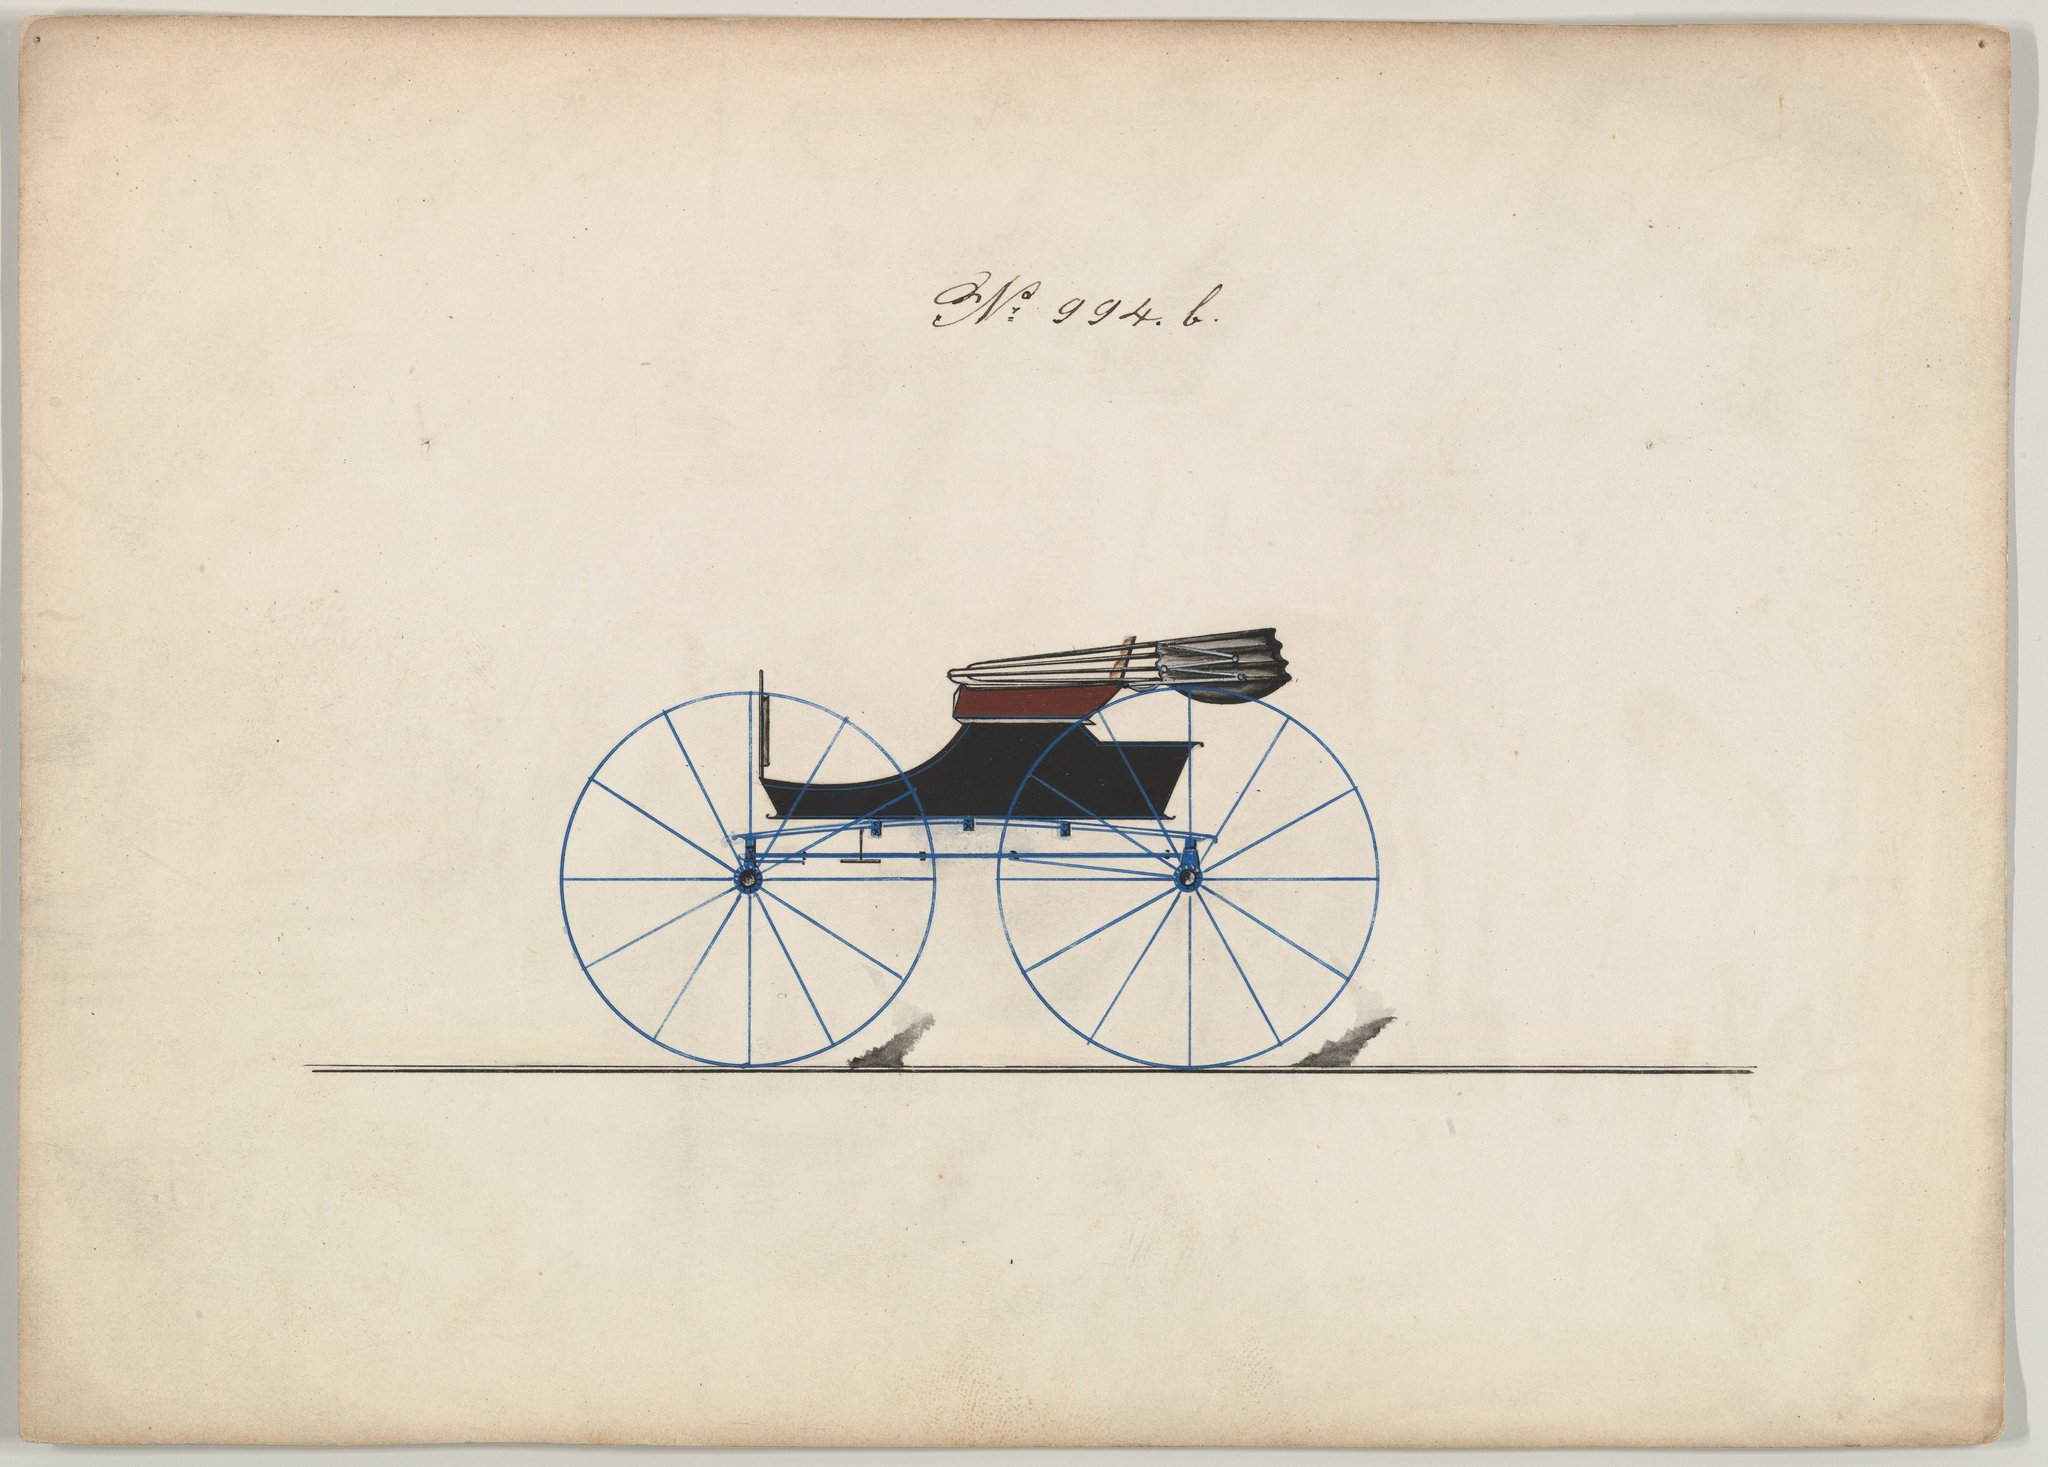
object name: drawing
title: Design for Wagon, no. 994b-2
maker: brewster & co.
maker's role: manufacturer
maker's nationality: american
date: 1870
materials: gouache, ink, watercolor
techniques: pen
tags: carriages